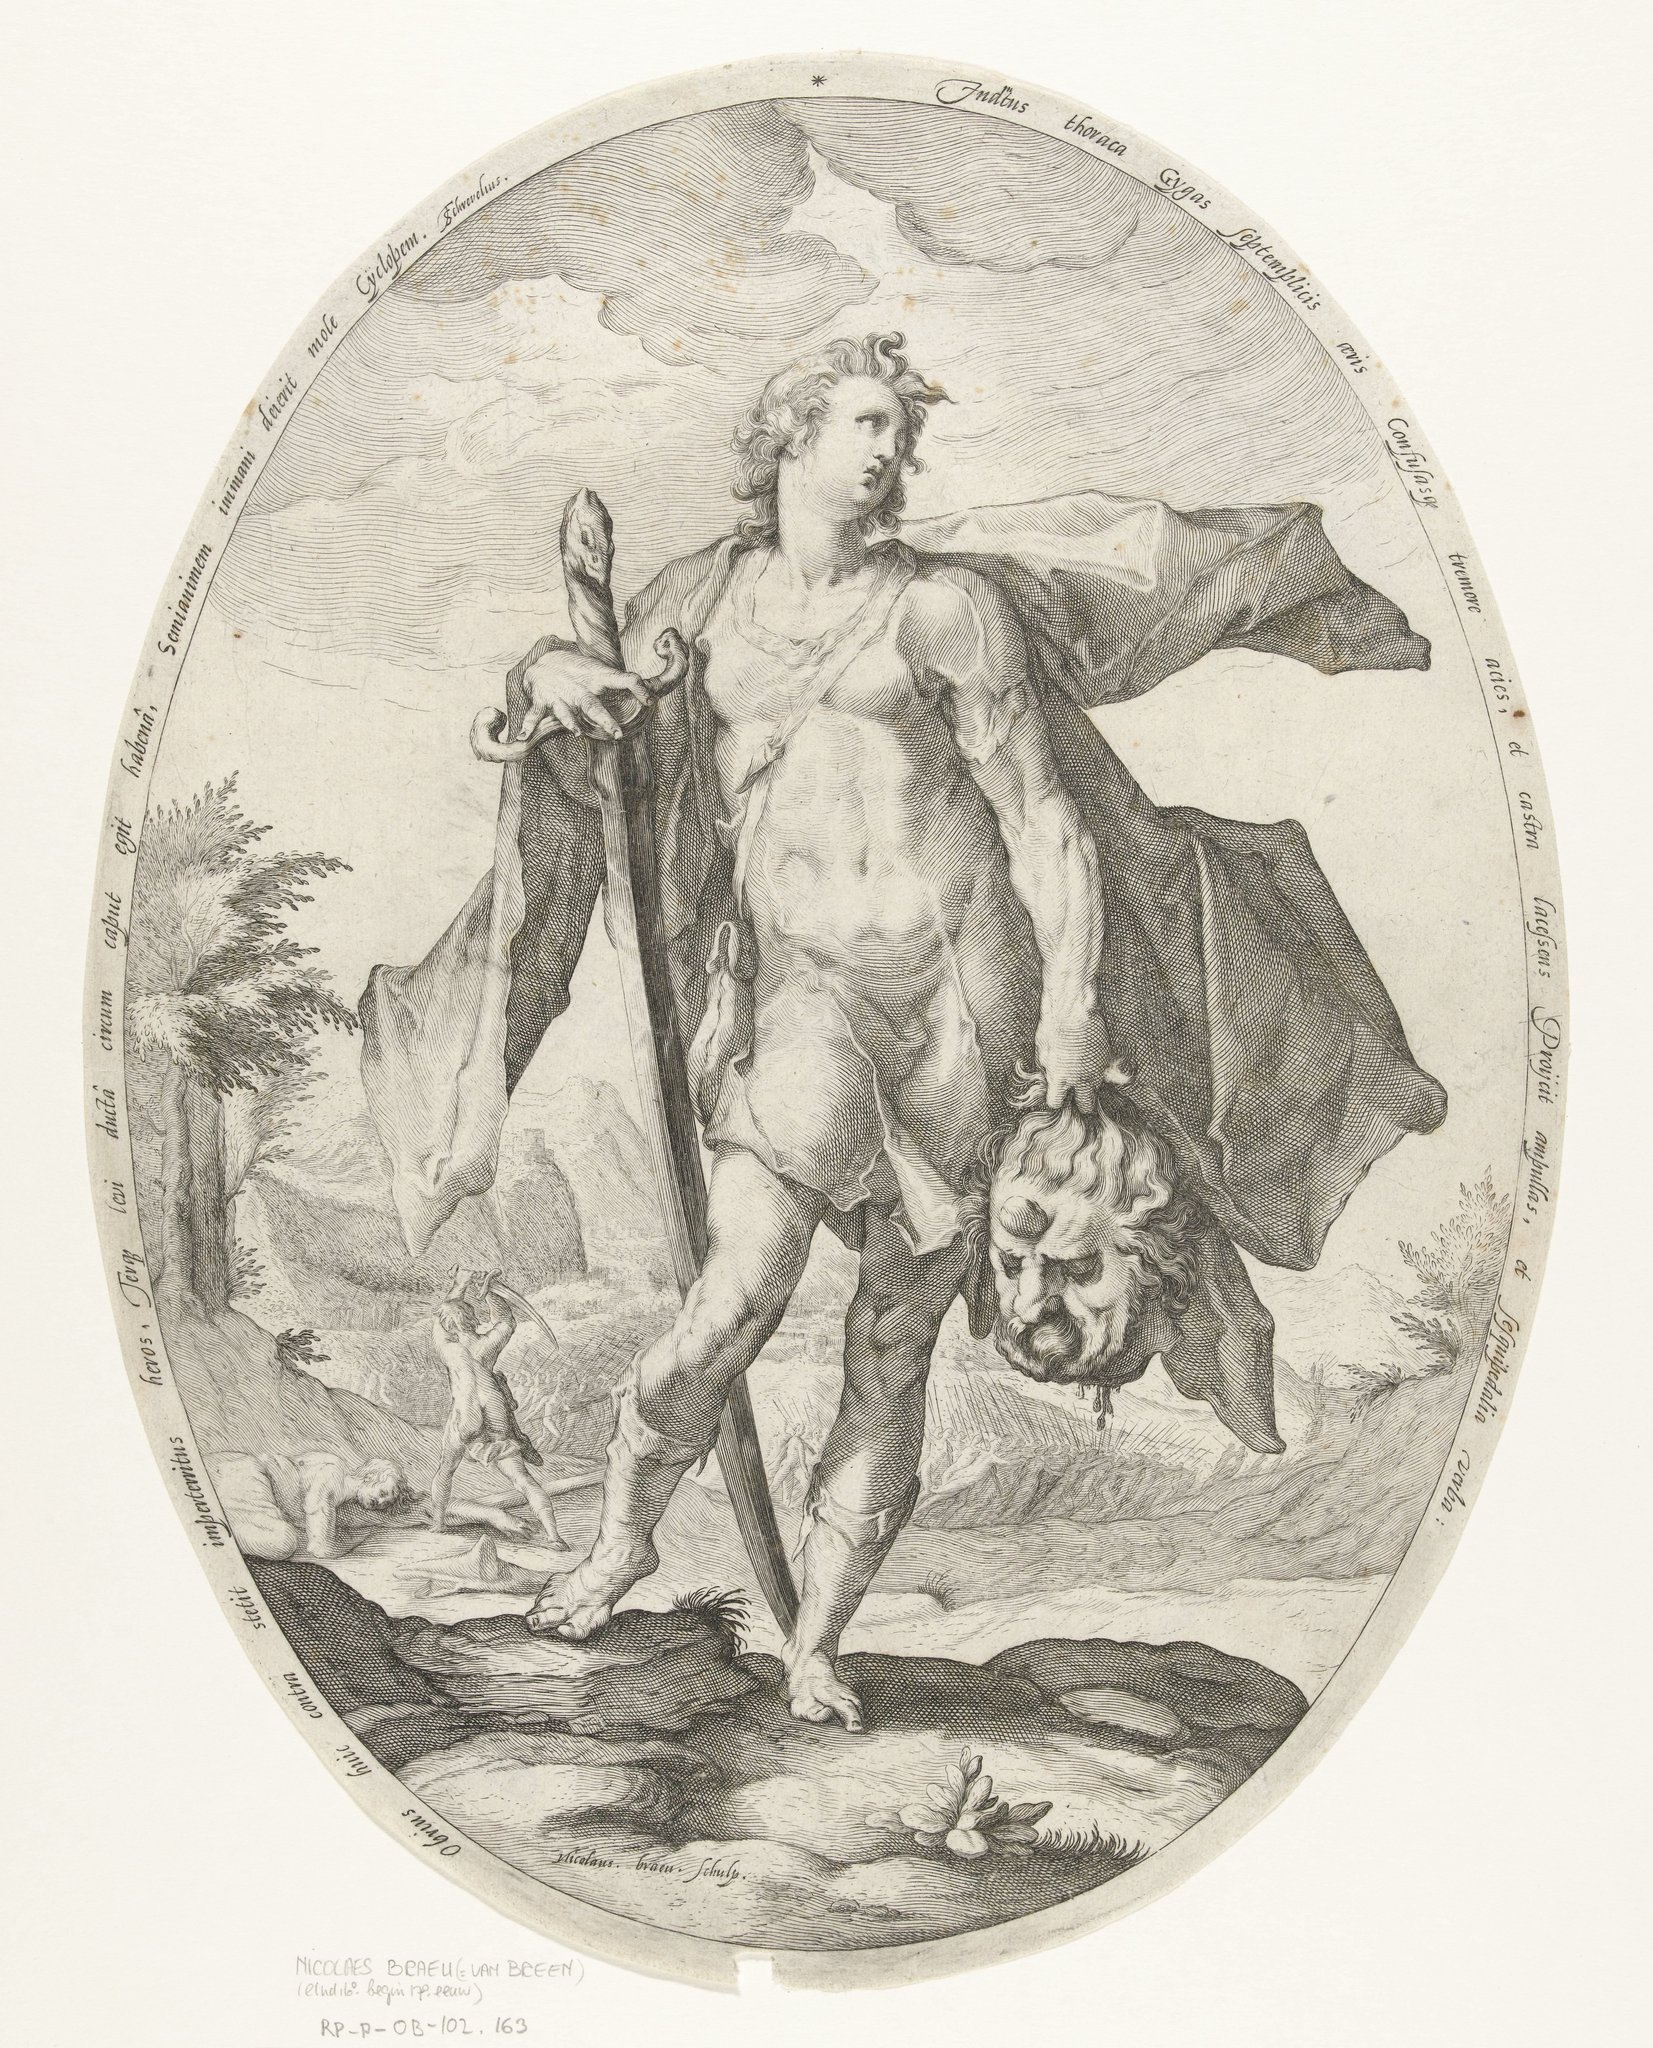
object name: print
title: Helden en heldinnen uit het Oude Testament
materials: paper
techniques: engraving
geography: netherlands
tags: david with goliath's head, david (not in biblical context); possible attributes: crown, harp, david beheads goliath with a sword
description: David leunt op Goliats zwaard en houdt het hoofd van Goliat in zijn hand. Op de achtergrond is te zien hoe David Goliats hoofd afhakt nadat hij hem met een steen van zijn slinger had geraakt. In de verte is het gevecht tussen de Israëliten en de Filistijnen in volle gang. In ovaal met randschrift in het Latijn door Theodorus Schrevelius.